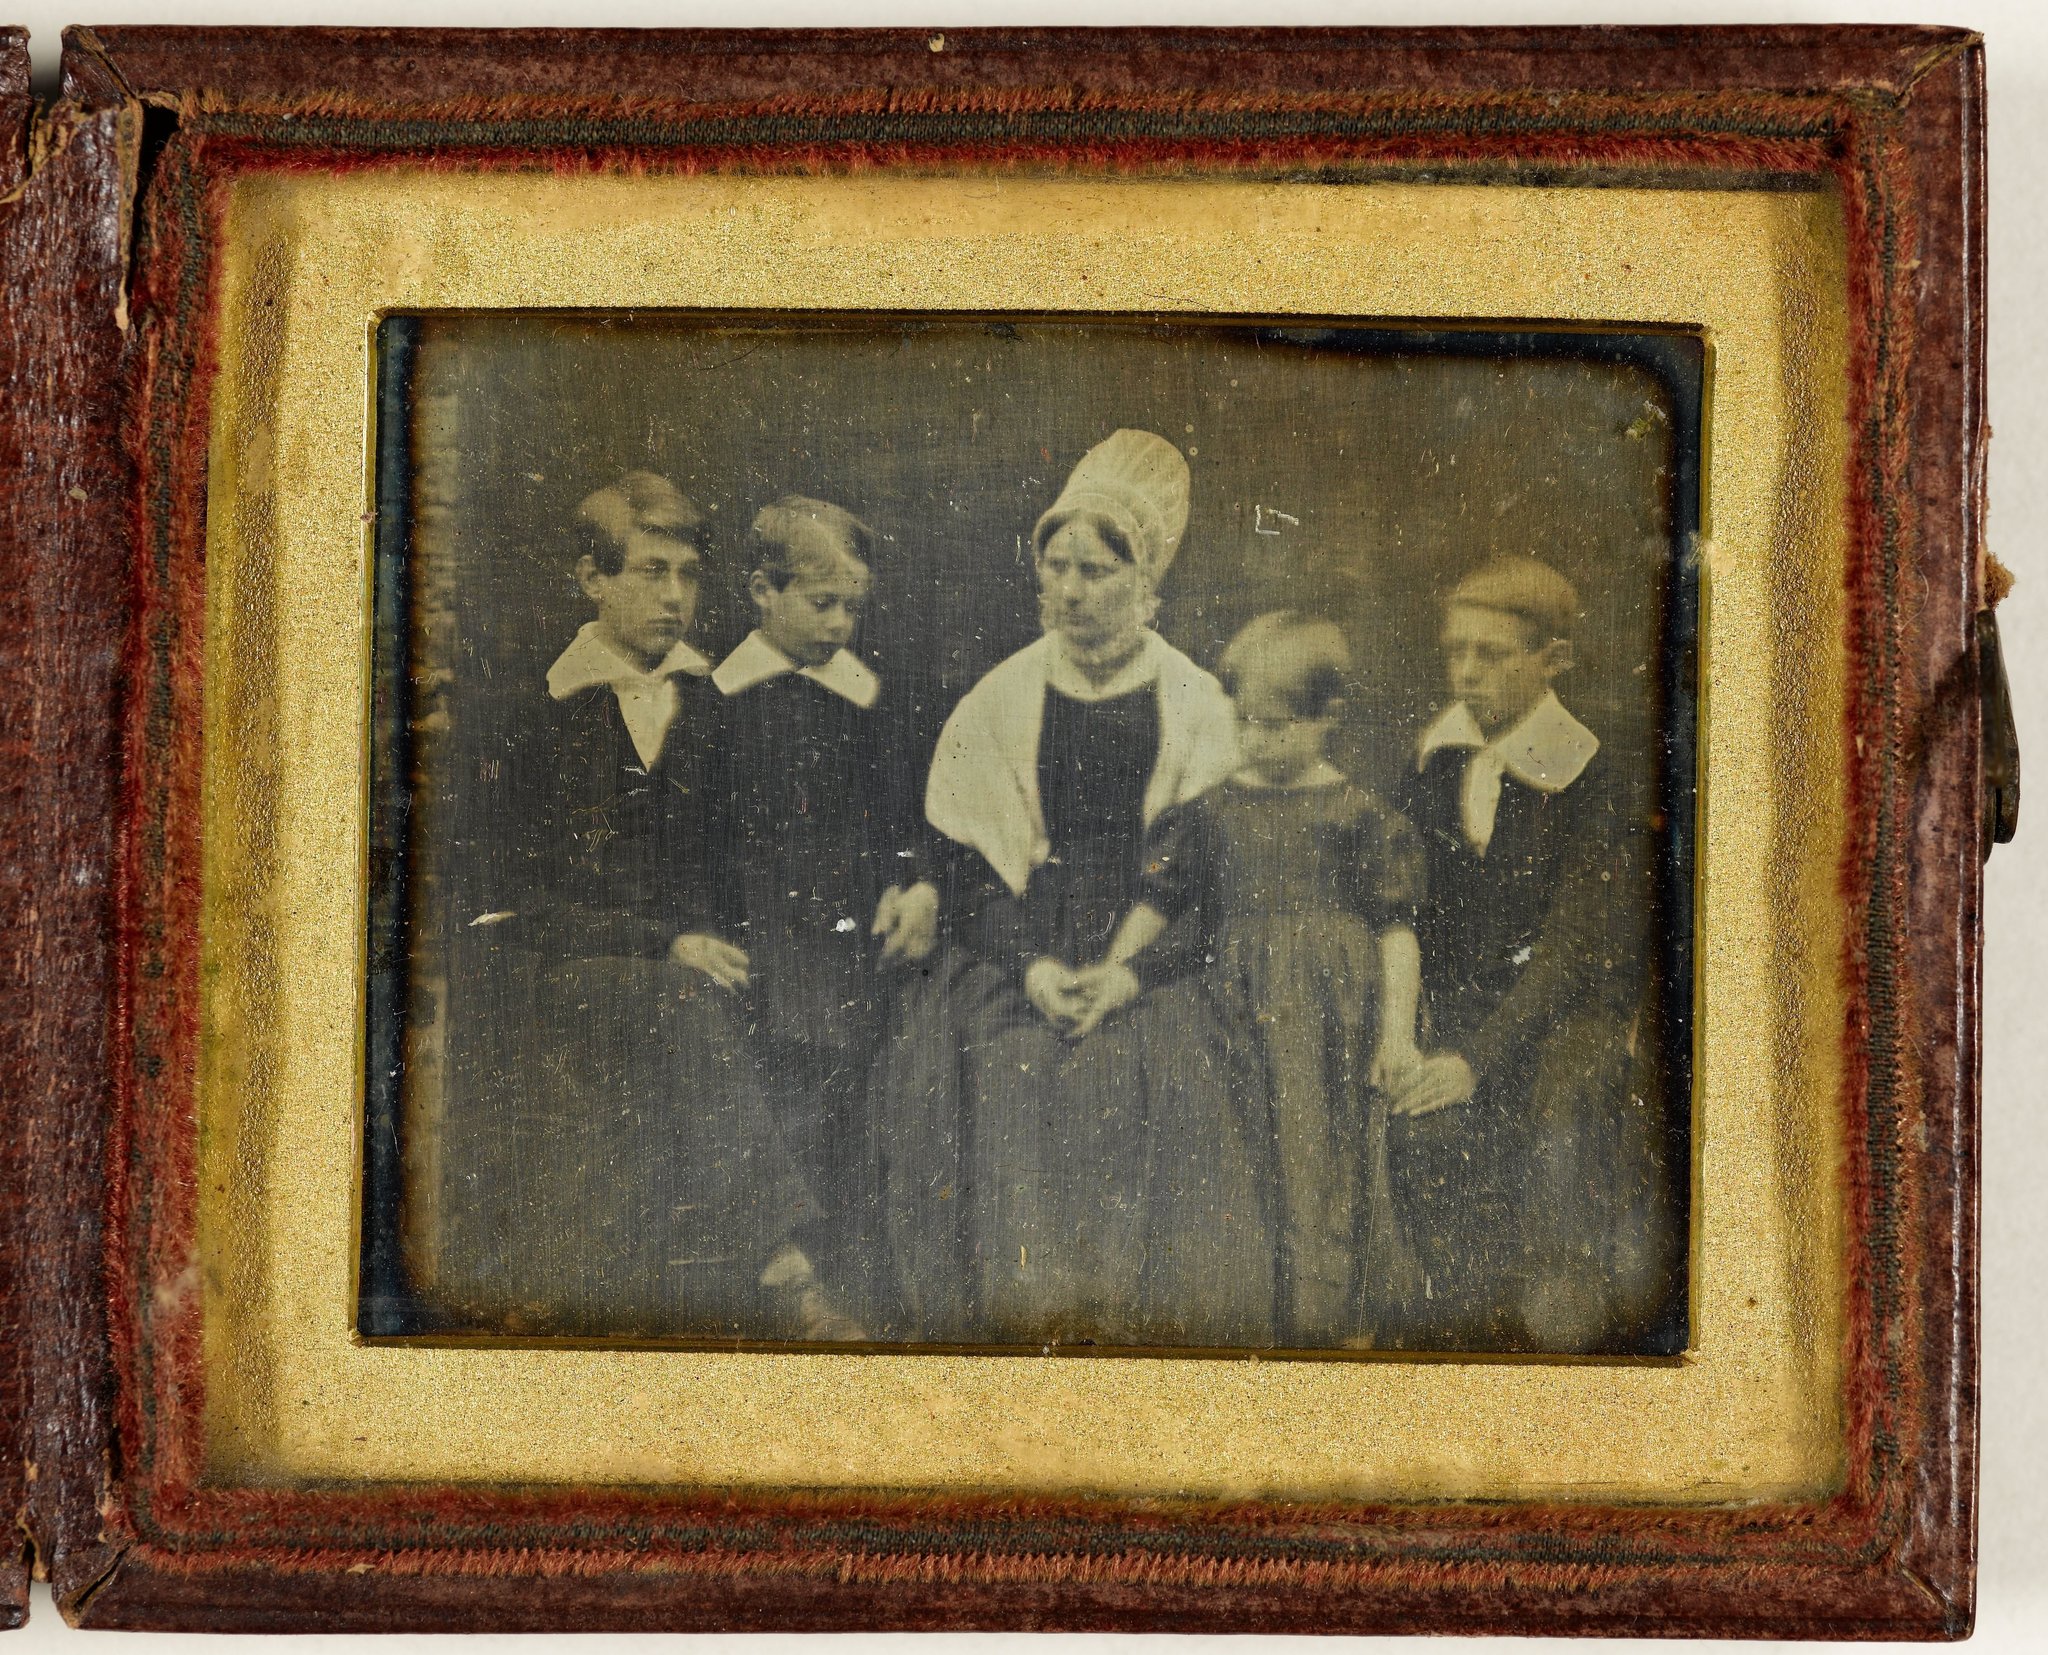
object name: photograph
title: Groepsportret van een onbekende vrouw en vier kinderen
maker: Anonymous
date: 1841-1855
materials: copper, glass, leather, velvet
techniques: daguerreotype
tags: mother and child(ren), woman and child(ren) (family group), anonymous historical persons portrayed in a group, in a group-portrait